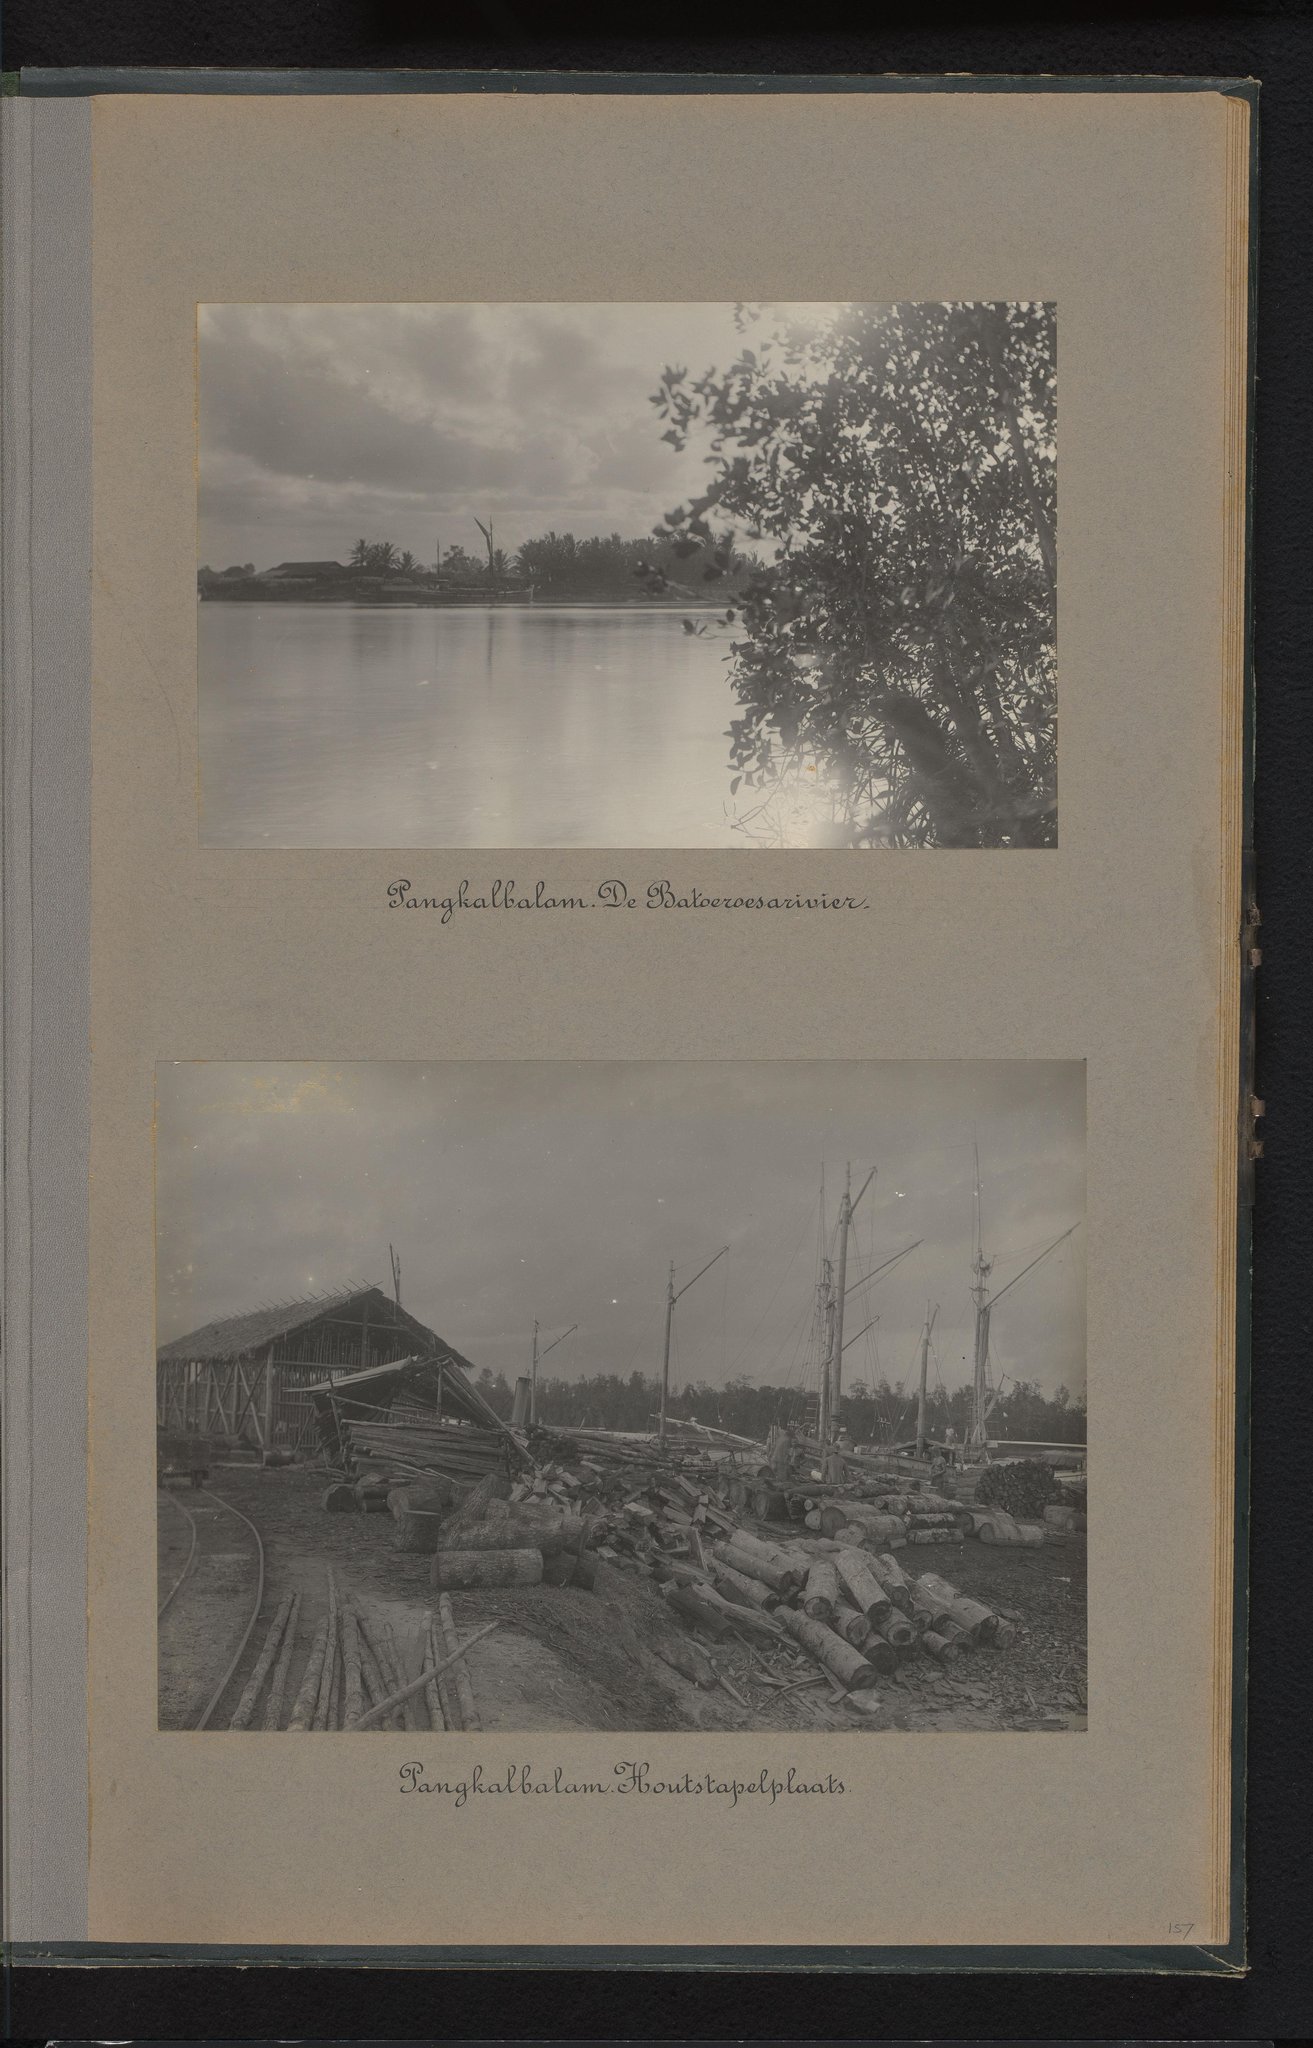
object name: photograph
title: Rivier en houtstapelplaats te Pangkalpinang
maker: Anonymous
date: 1914-1919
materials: cardboard, photographic support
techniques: gelatin silver print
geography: bangka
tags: robert julius boers, harbour, colonial system, mining, transport of timber, timber-trailer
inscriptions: inscription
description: Albumblad met 2 foto's van de rivier en de houtstapelplaats in de haven van de mijnbouwonderneming te Pangkalpinang. Onderdeel van het fotoalbum aangeboden aan Robert Julius Boers bij zijn vertrek naar Nederland in 1919 door het personeel van de Banka-tinwinning.